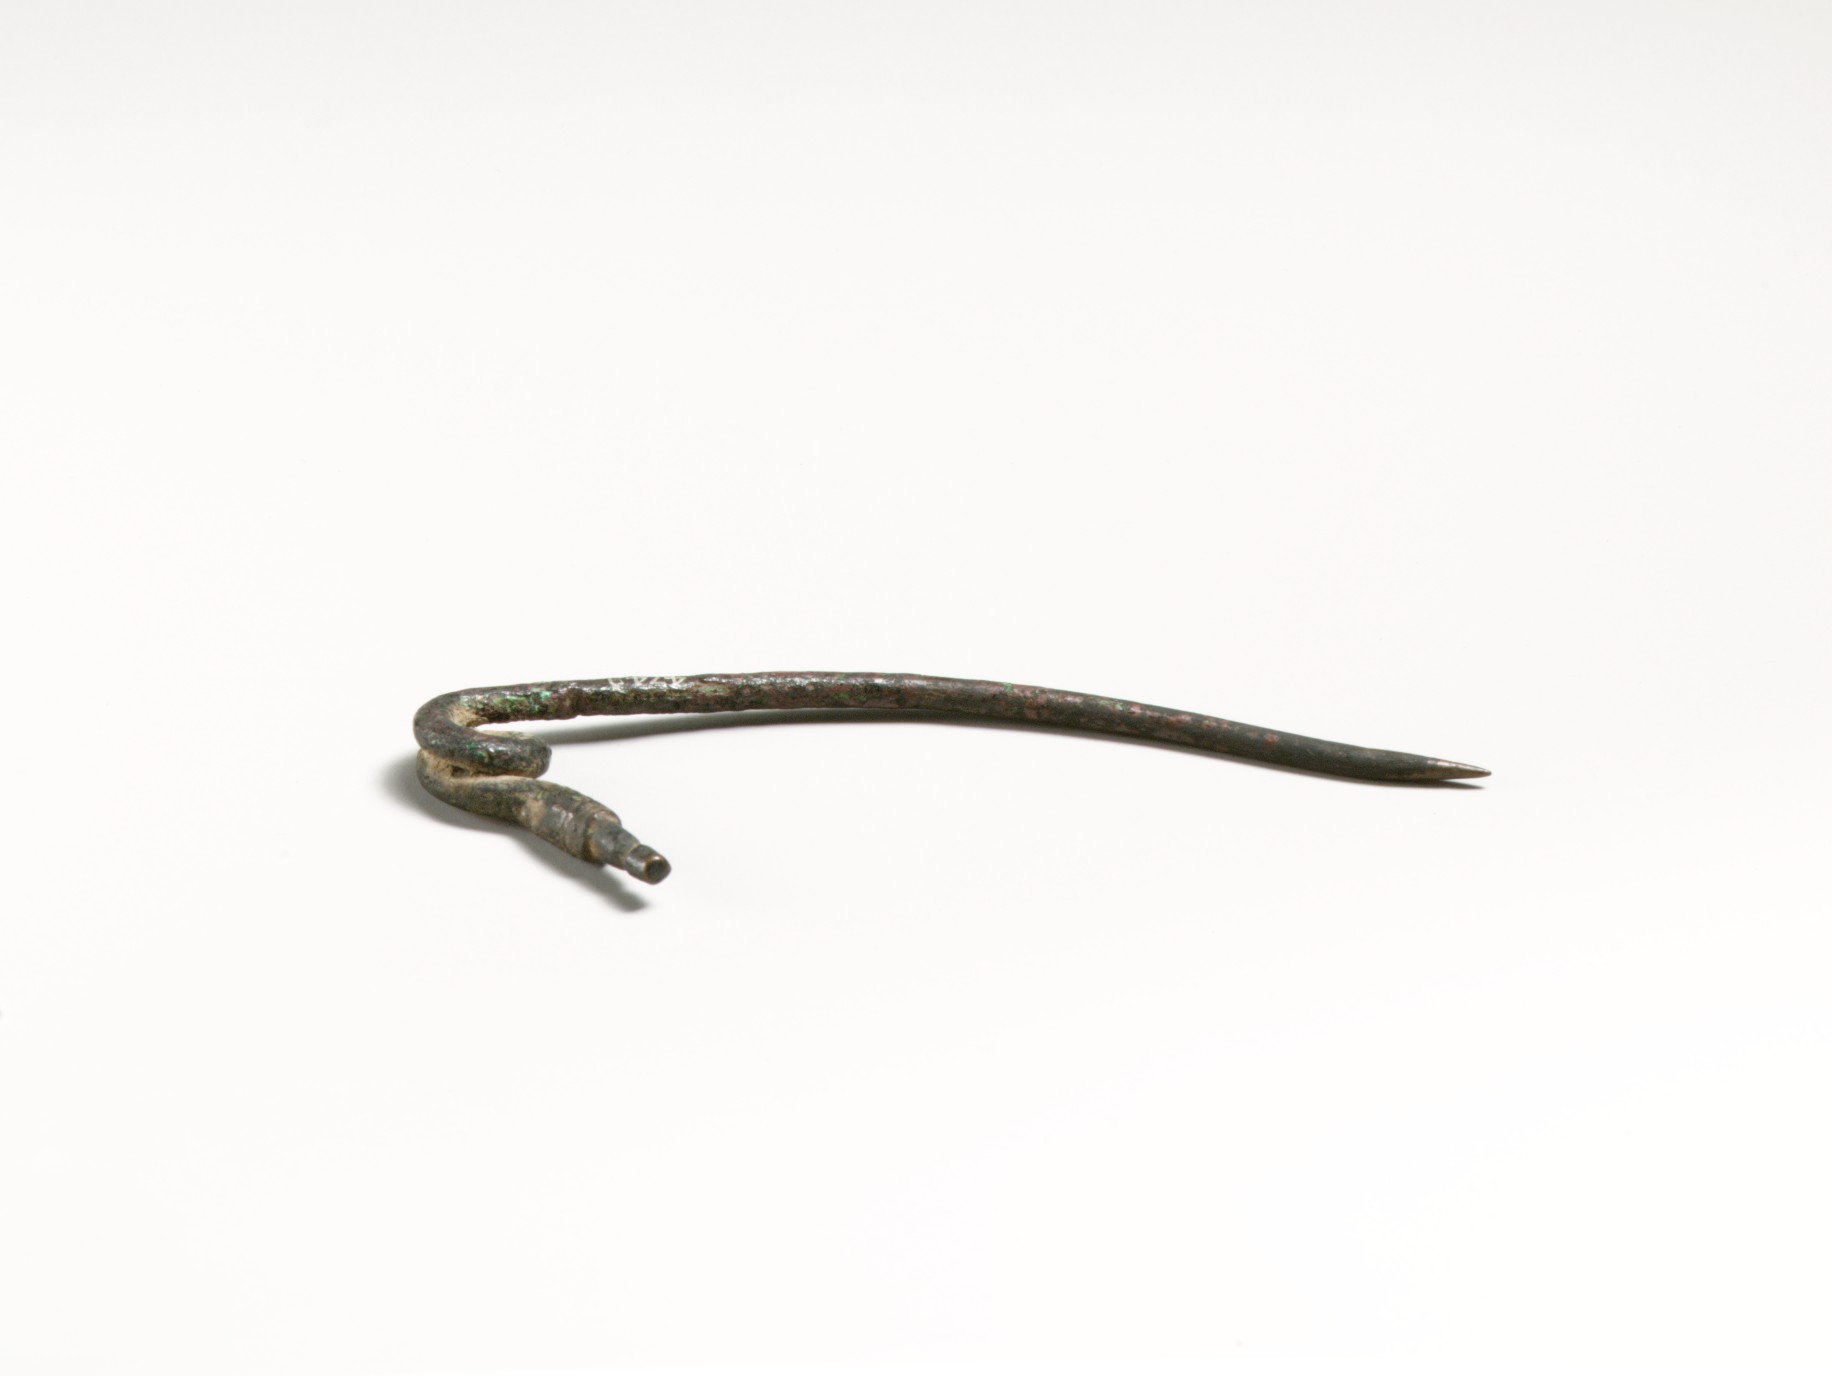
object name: fibula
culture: cypriot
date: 3900 BCE-100 CE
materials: bronze